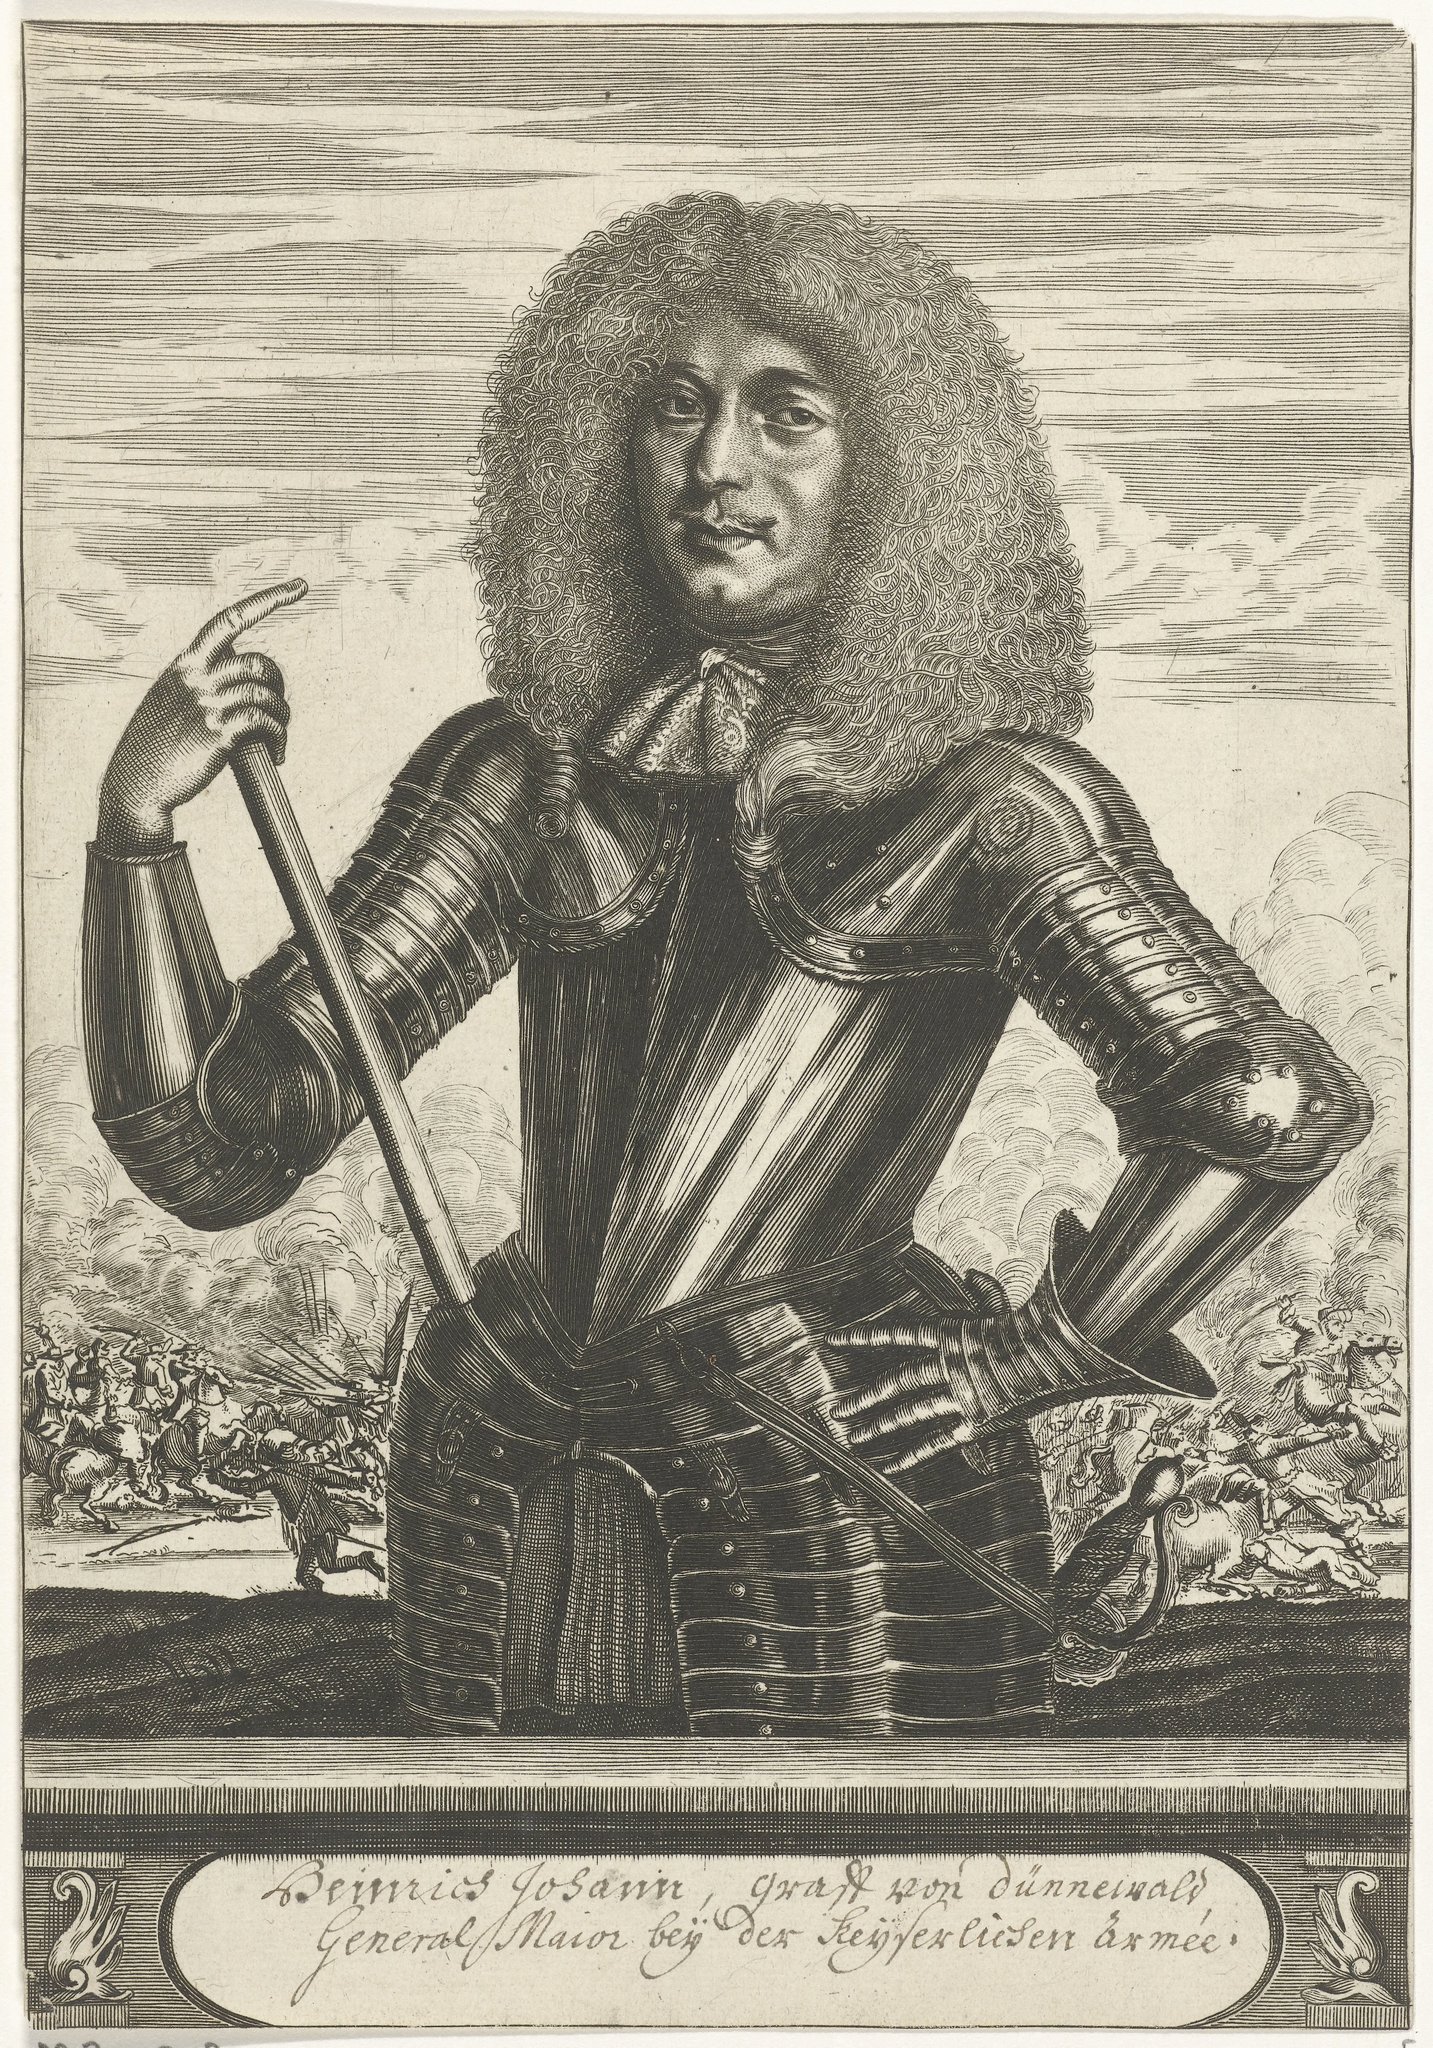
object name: print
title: Portret van Heinrich Johann, graaf van Dunnewald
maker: christiaan hagen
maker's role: draughtsman, print maker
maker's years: 1635-1707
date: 1635-1695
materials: paper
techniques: engraving, etching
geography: amsterdam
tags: battle (+ cavalry, horsemen), military clothing and other equipment (uniforms, cap, armour, helmet, etc.)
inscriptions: collector's mark: Lugt 2228, inscription: ‘Heinrich Johann, graeff von Dünnewald, General Maior beij der keijzerlichen armée.’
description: Portret van Heinrich Johann, graaf van Dunnewald, gekleed in een harnas met in zijn rechterhand een commandostaf. Op de achtergrond is een ruiterslag afgebeeld. Onder zijn portret een plint, waarop in een handschrift in pen zijn naam en titel in twee regels in een cartouche.